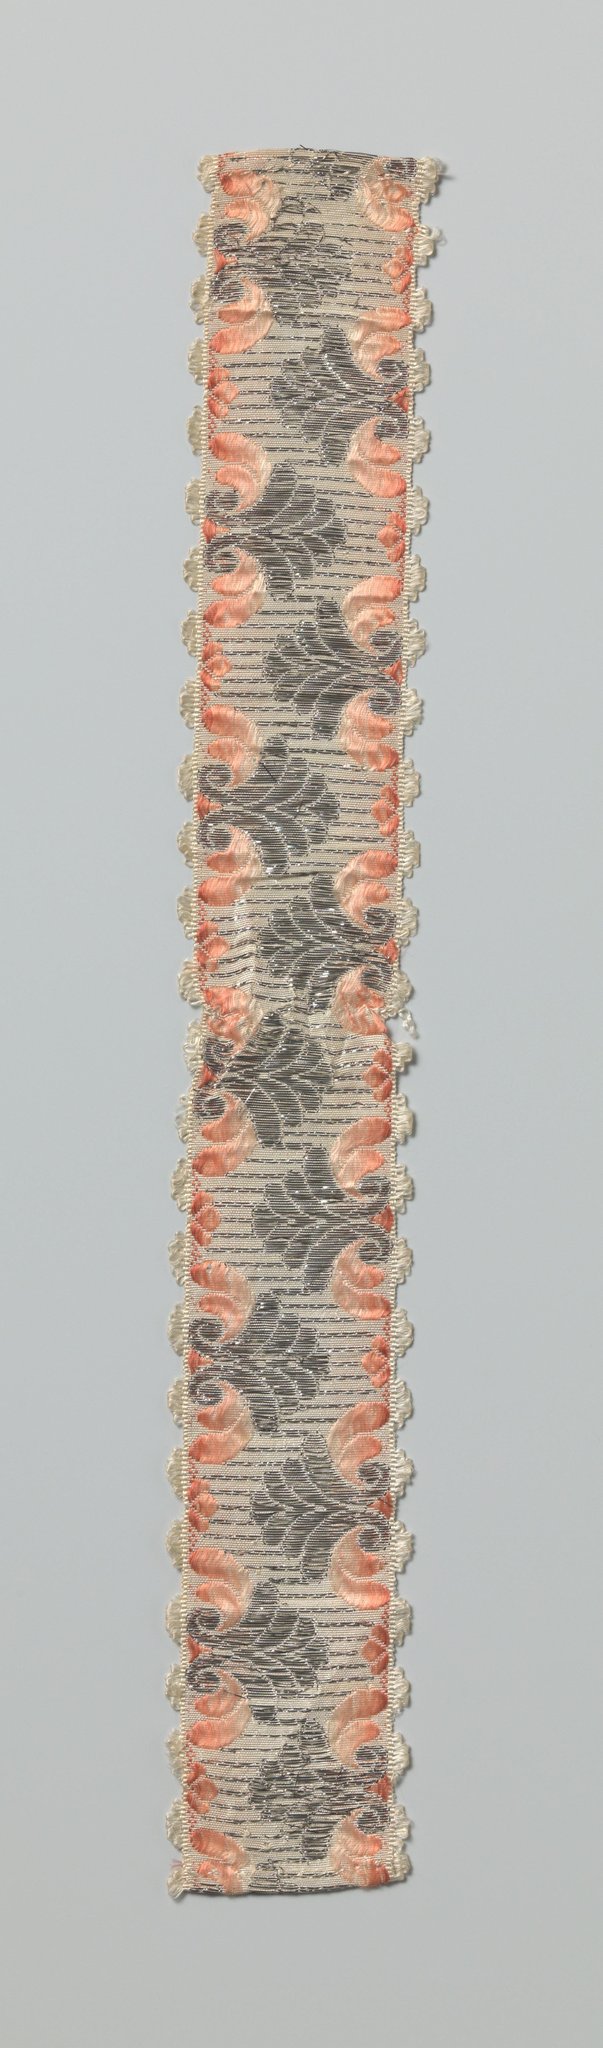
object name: ribbon material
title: Lint, zalmkleur, wit en zilver, fond van de gros de Tours met dwarsstreepjes van zilverlamé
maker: Anonymous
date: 1750-1770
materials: silk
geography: france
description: Lint voor kousebanden, met gelijk patroon: Een lint in zalmkleur, wit en zliver. Techniek: Fond van gros de Tours in wit met dwarsstreepjes van Zilverlamé. Het ornament in deels van gebrocheerd zilverlamé, dat flottant is totaan de omstrekken, deels van witte, blauwe of zalmkleurge zijden ketting draden, die eveneens flottant liggen. Patroon: Toegewende, in elkaar grijpende klassieke palmetten hebben zilveren, binnenbladeren en buitenbladeren in de respectievelijke en verbloeiende kleuren, hanekamzelfkanten.